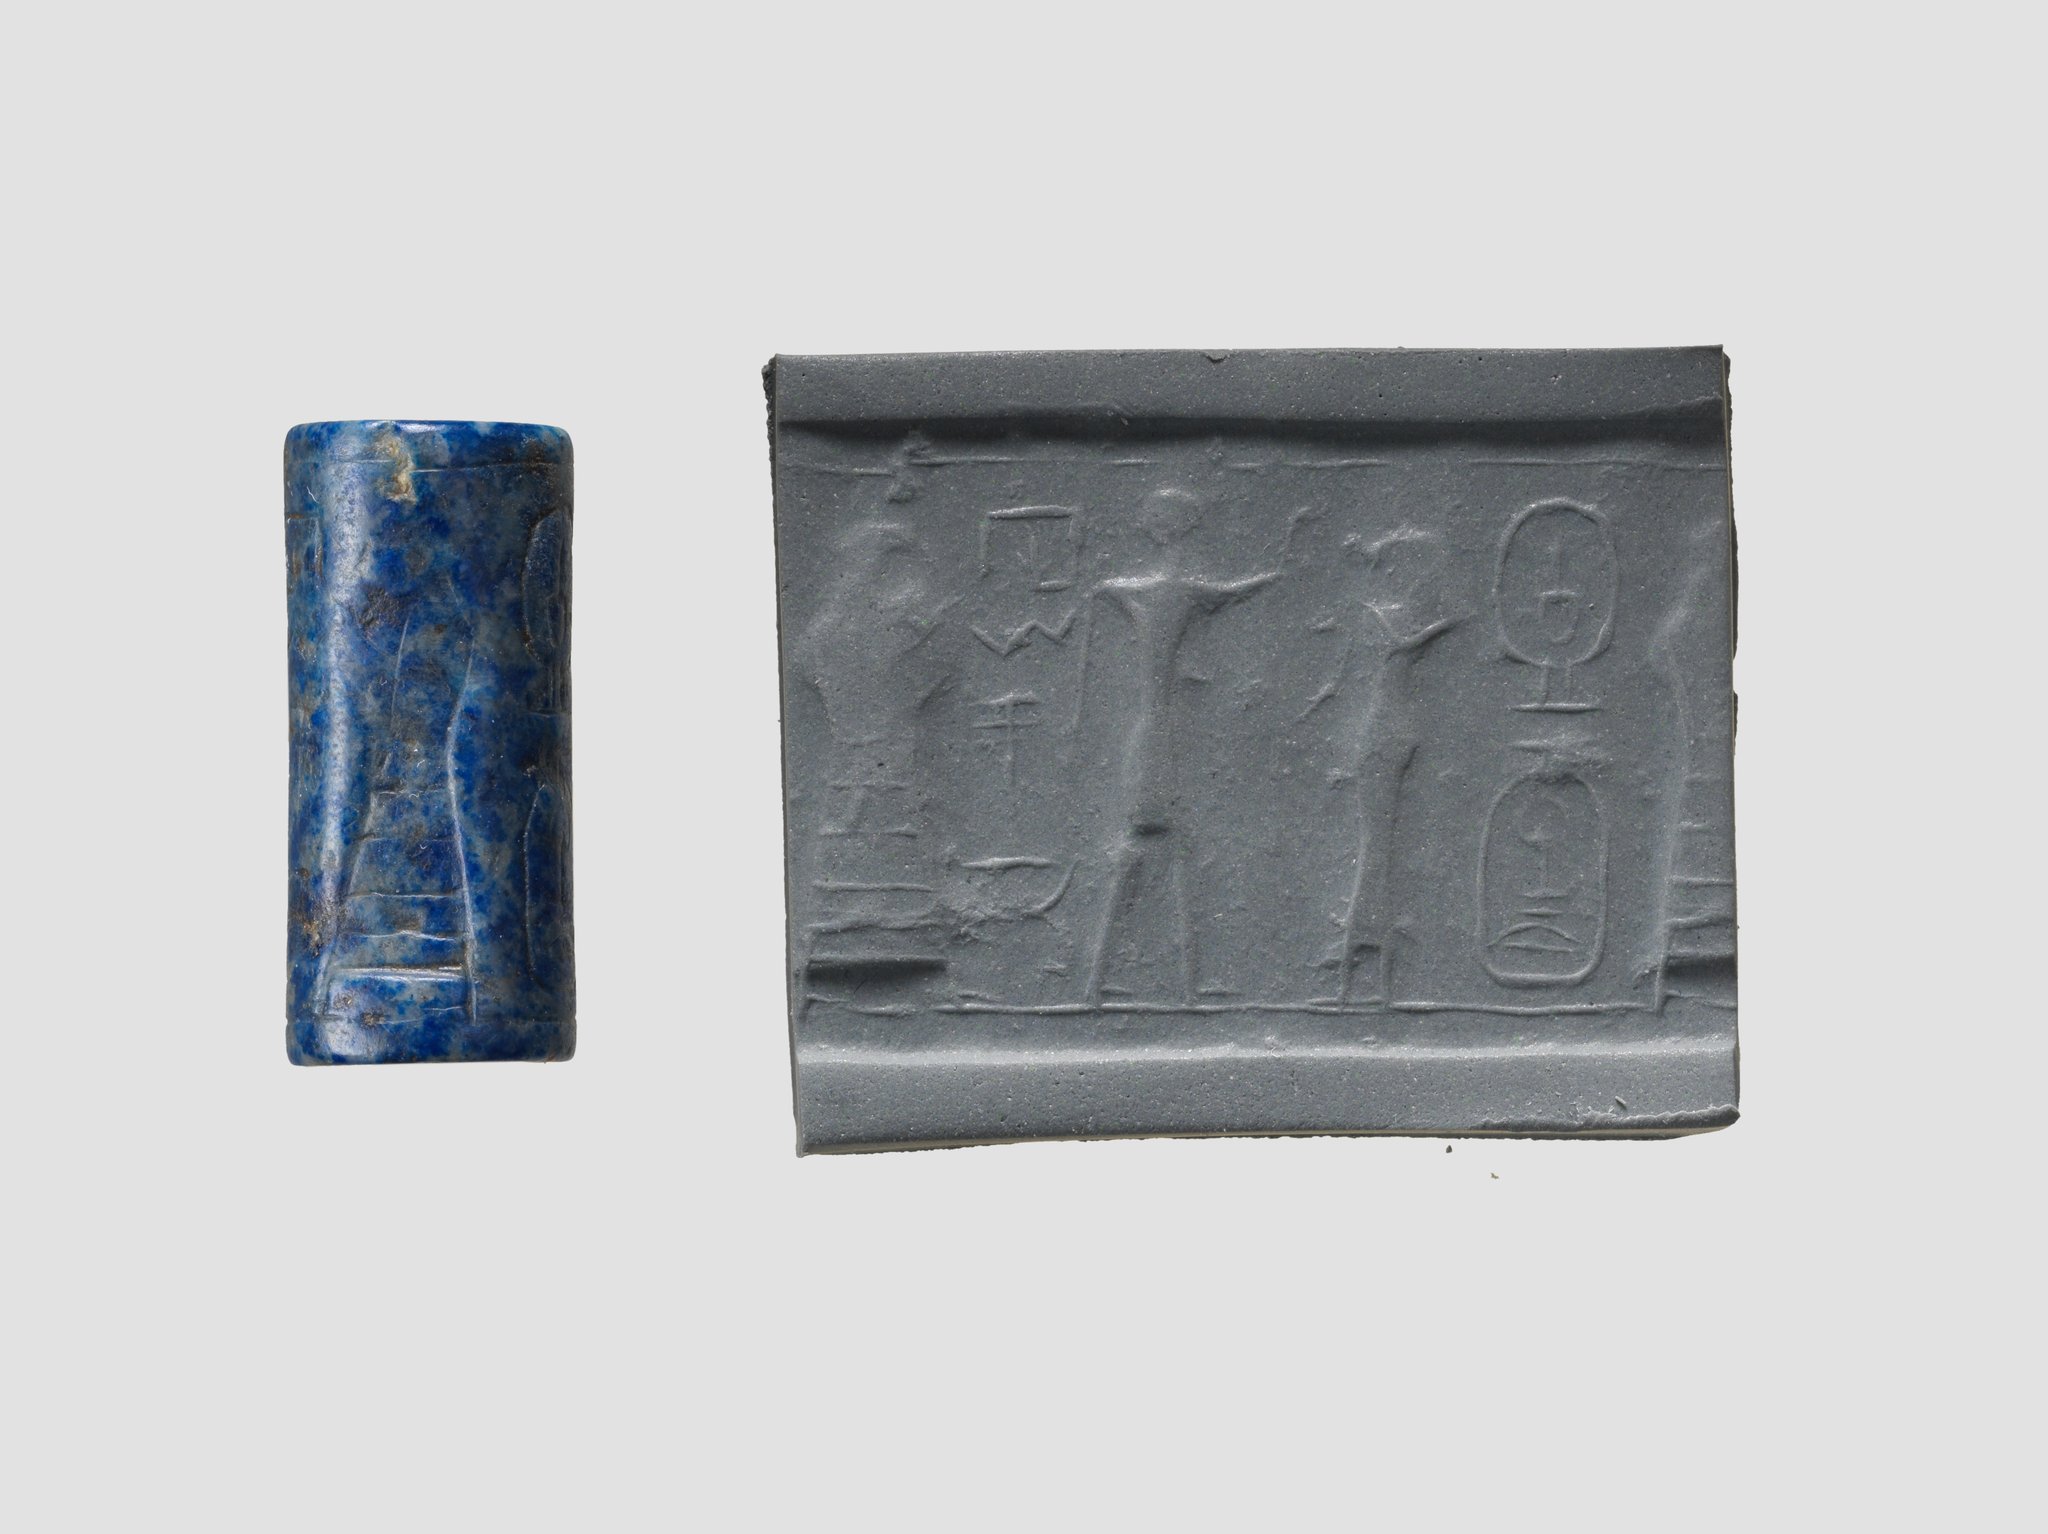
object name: cylinder seal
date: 1500 BCE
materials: stone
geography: levant